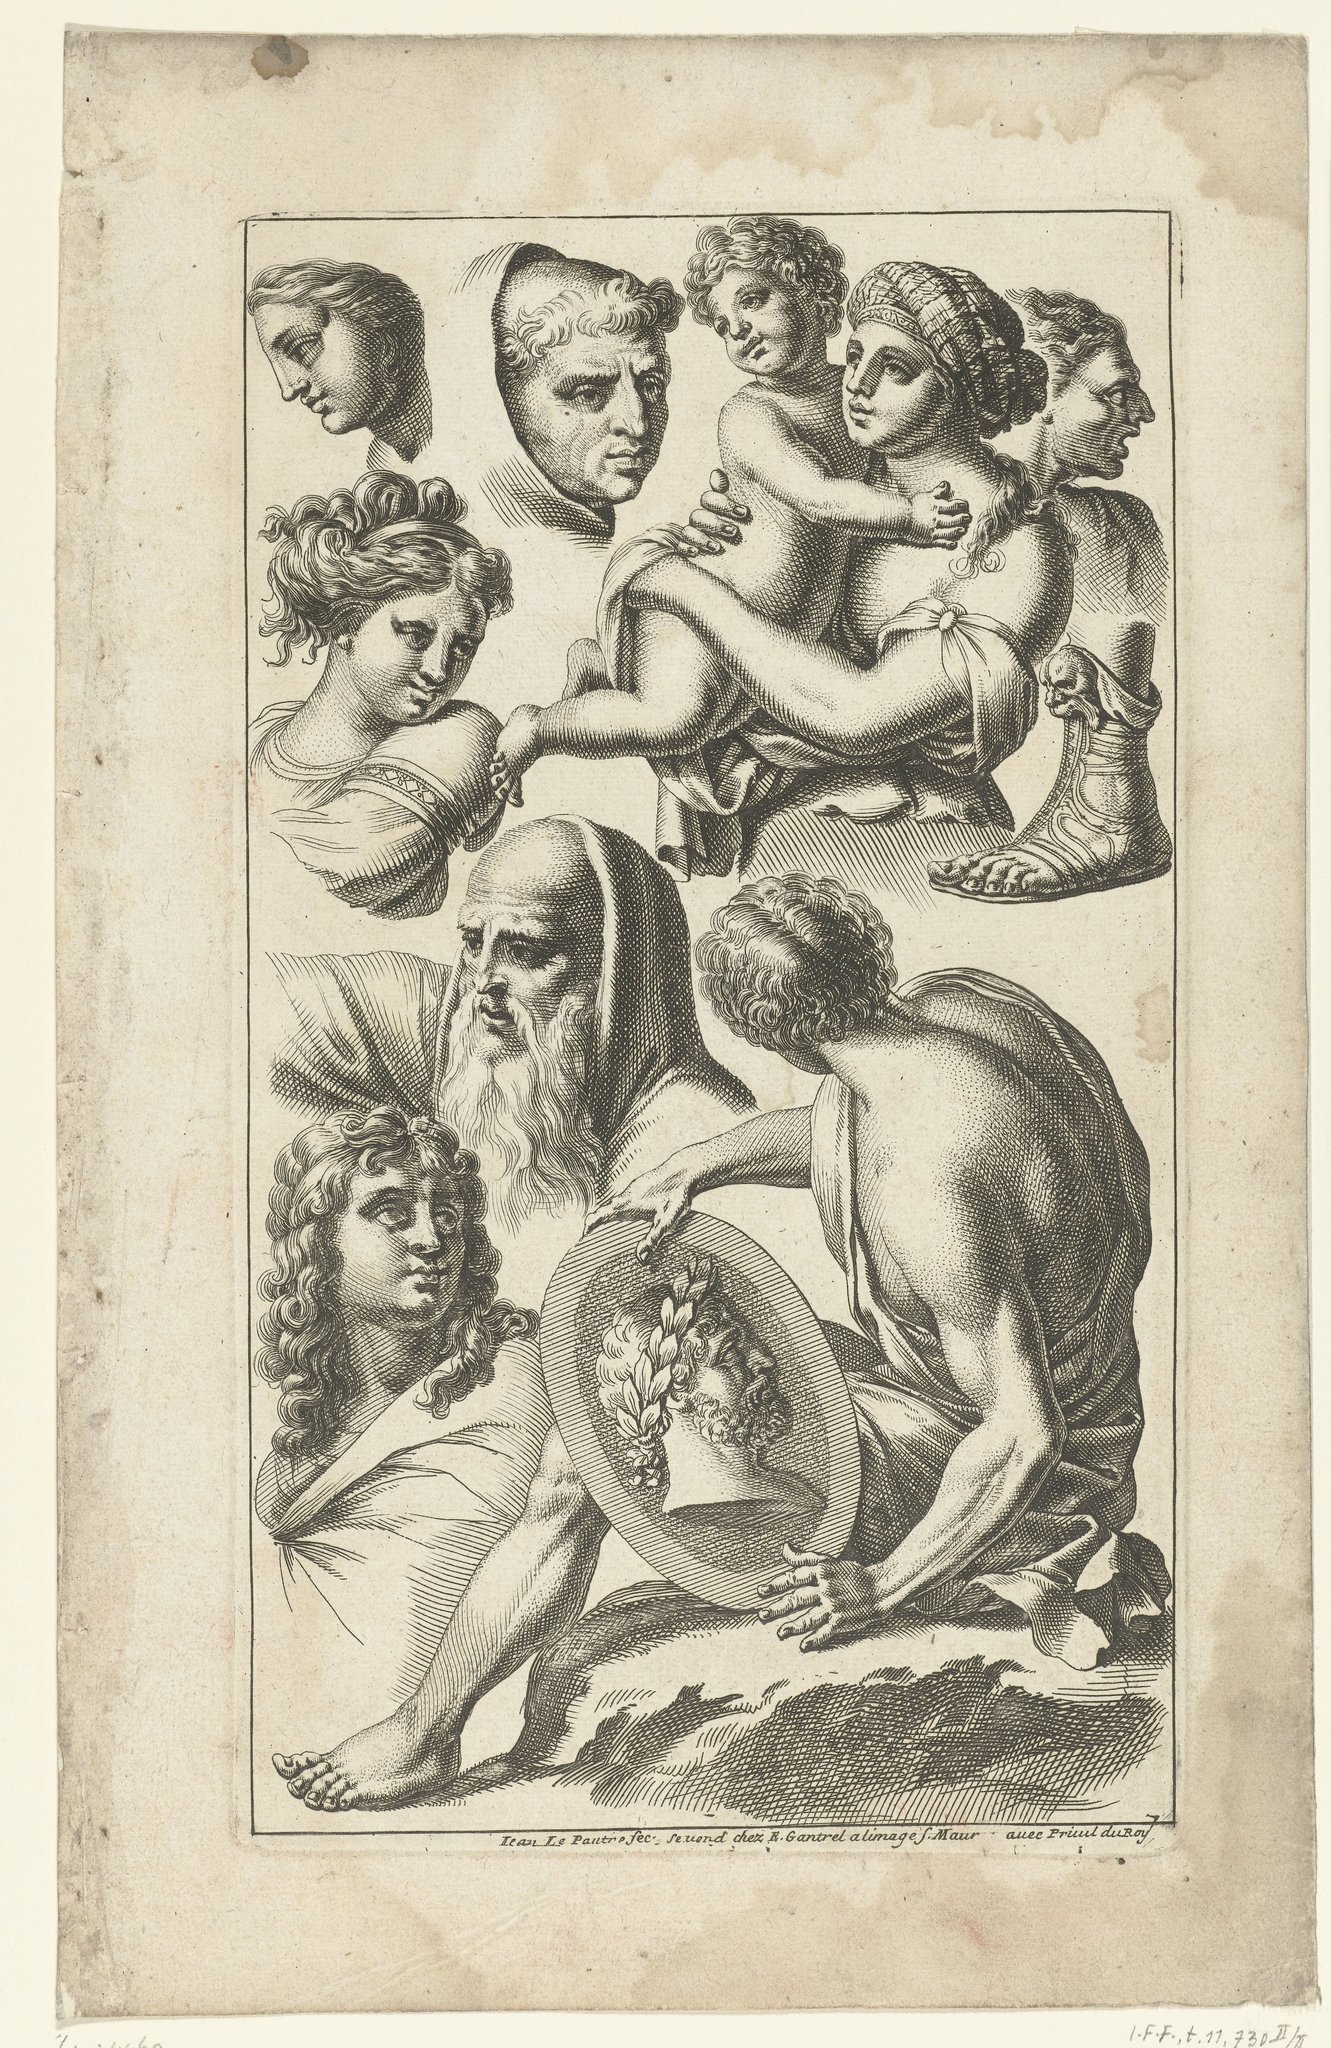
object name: print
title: Studies van hoofden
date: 1682-1706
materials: paper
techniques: engraving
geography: paris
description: Onderaan zit een jongeling, gezien van opzij, met een ovaal medaillon in de hand waarop een keizersbuste staat. Uit tweede editie.